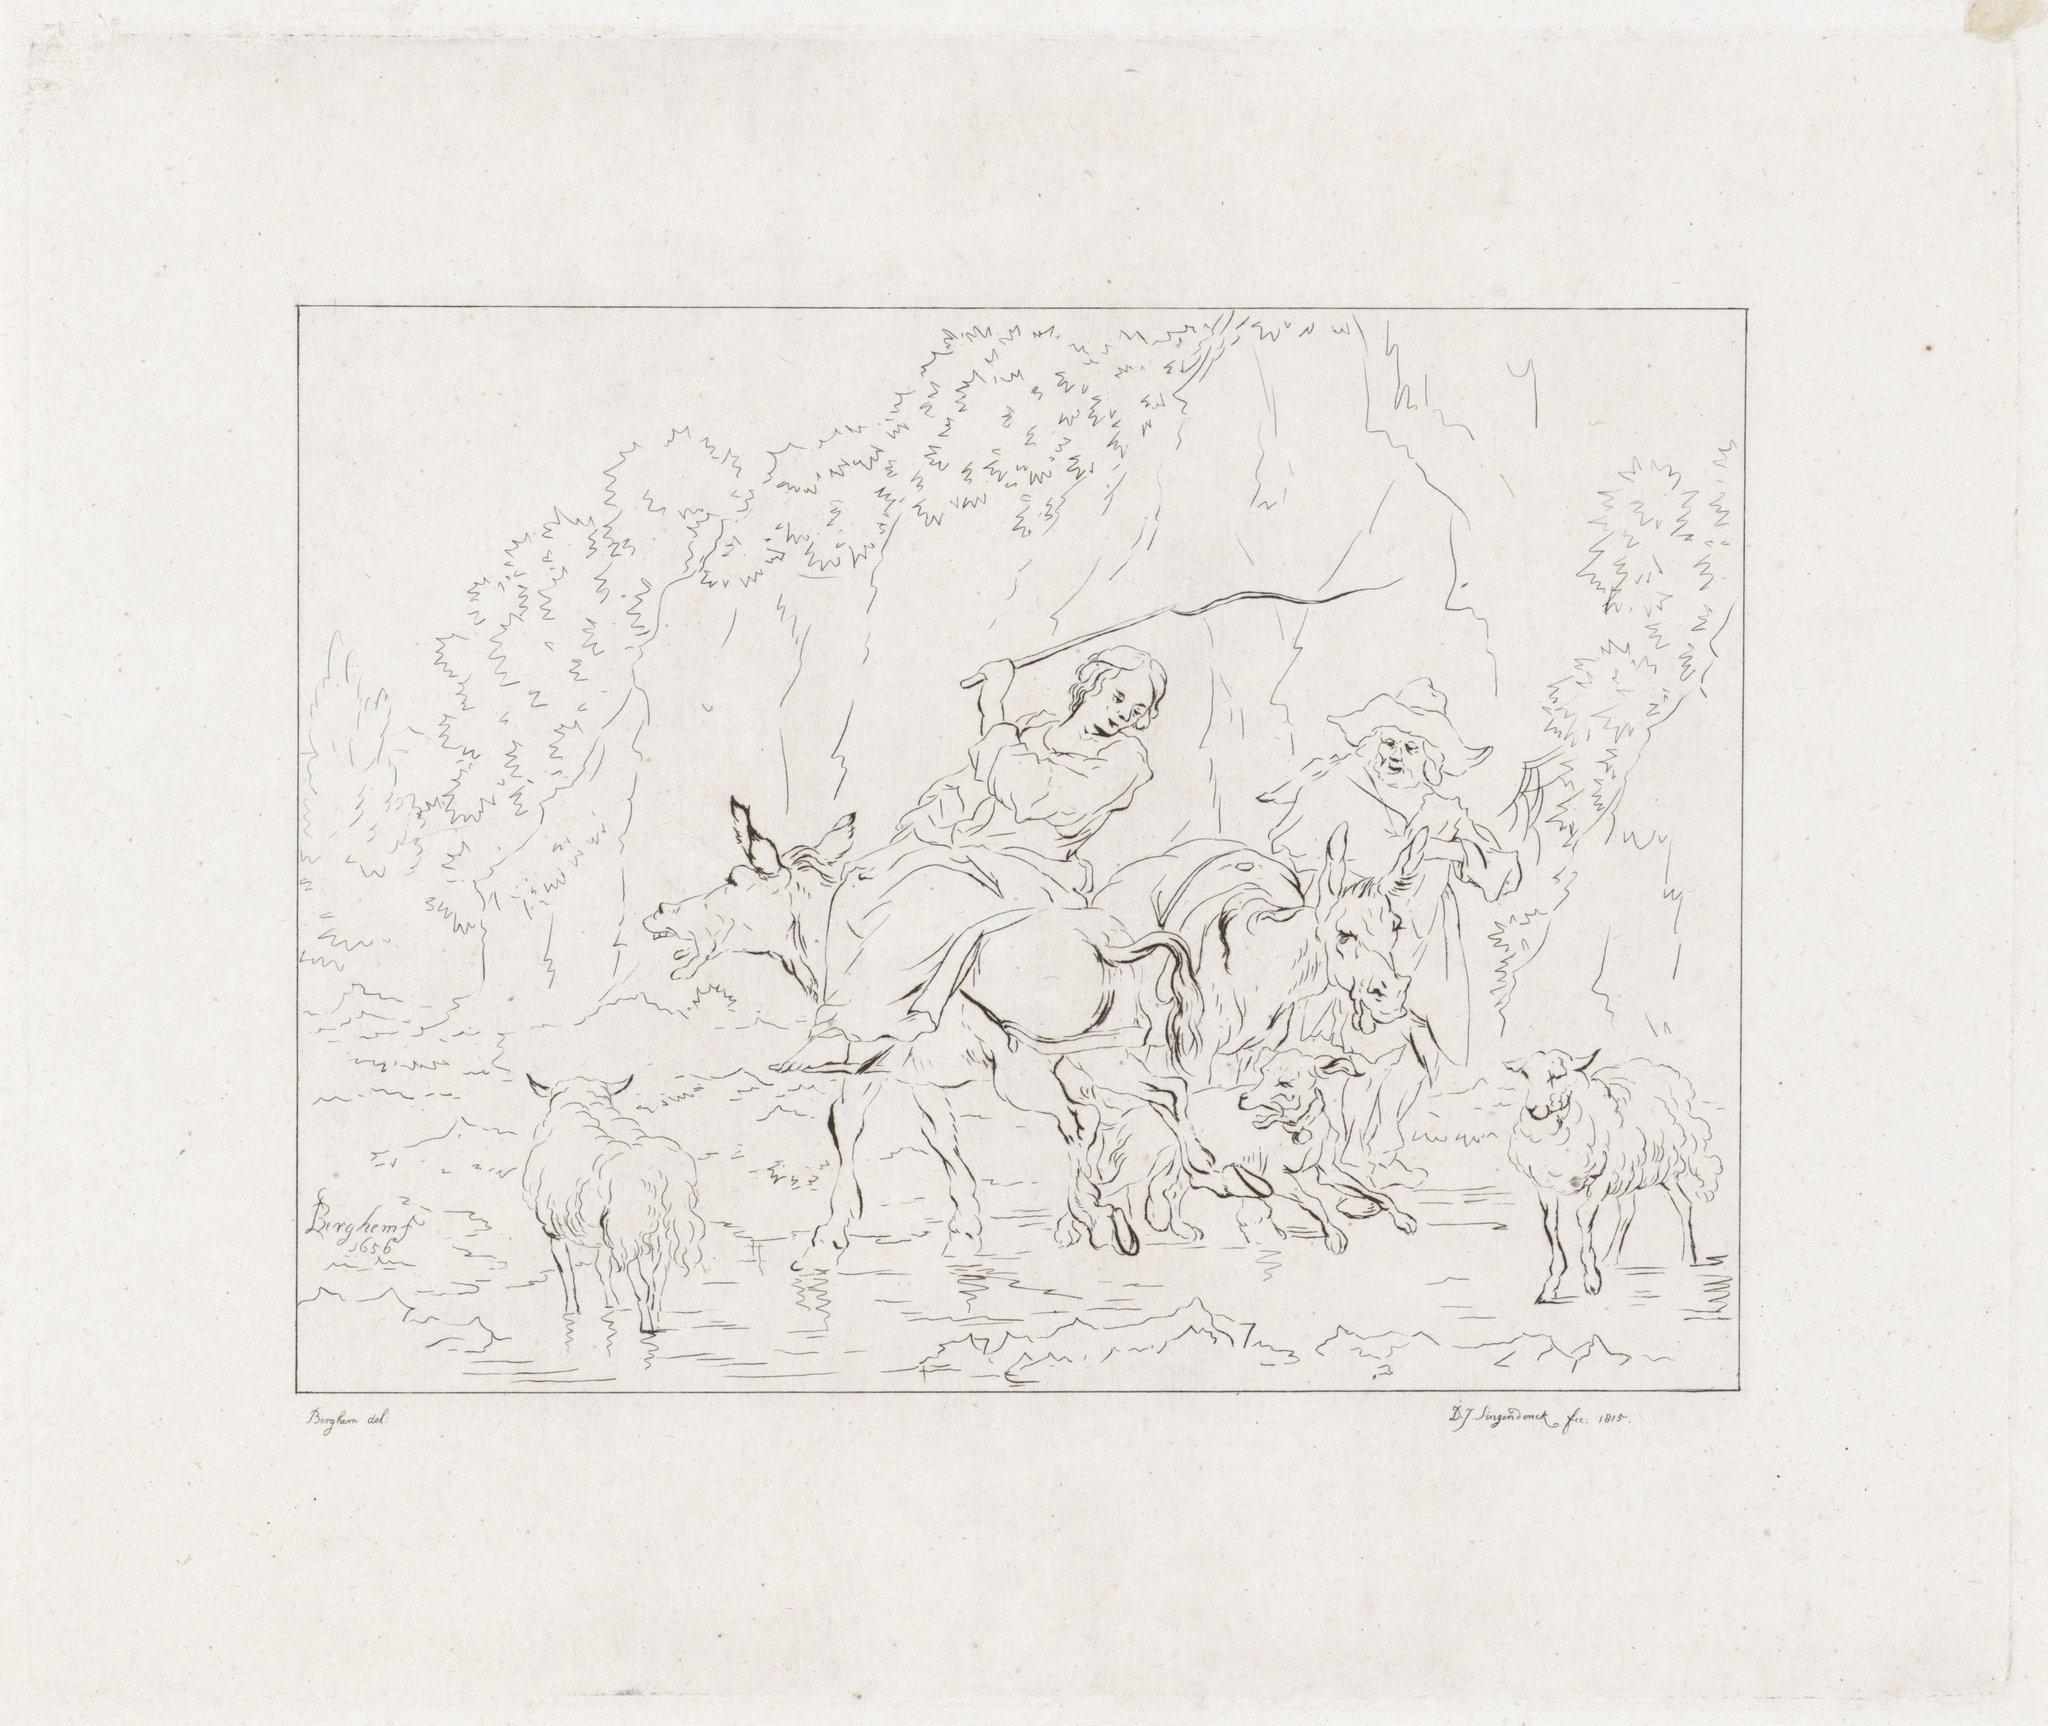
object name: print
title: Herder en herderin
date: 1815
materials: paper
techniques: etching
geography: utrecht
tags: pastorals, arcadian scenes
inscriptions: collector's mark: Lugt 2228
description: Een herderin zit op een balkende ezel, die een stroompje oversteekt, daarbij schoppend met zijn achterpoten. Zij houdt een tak boven haar hoofd en kijkt naar een hond die naar de achterpoten van haar ezel springt. Een herder met een tweede ezel staat aan de waterkant. In het water staan twee schapen.